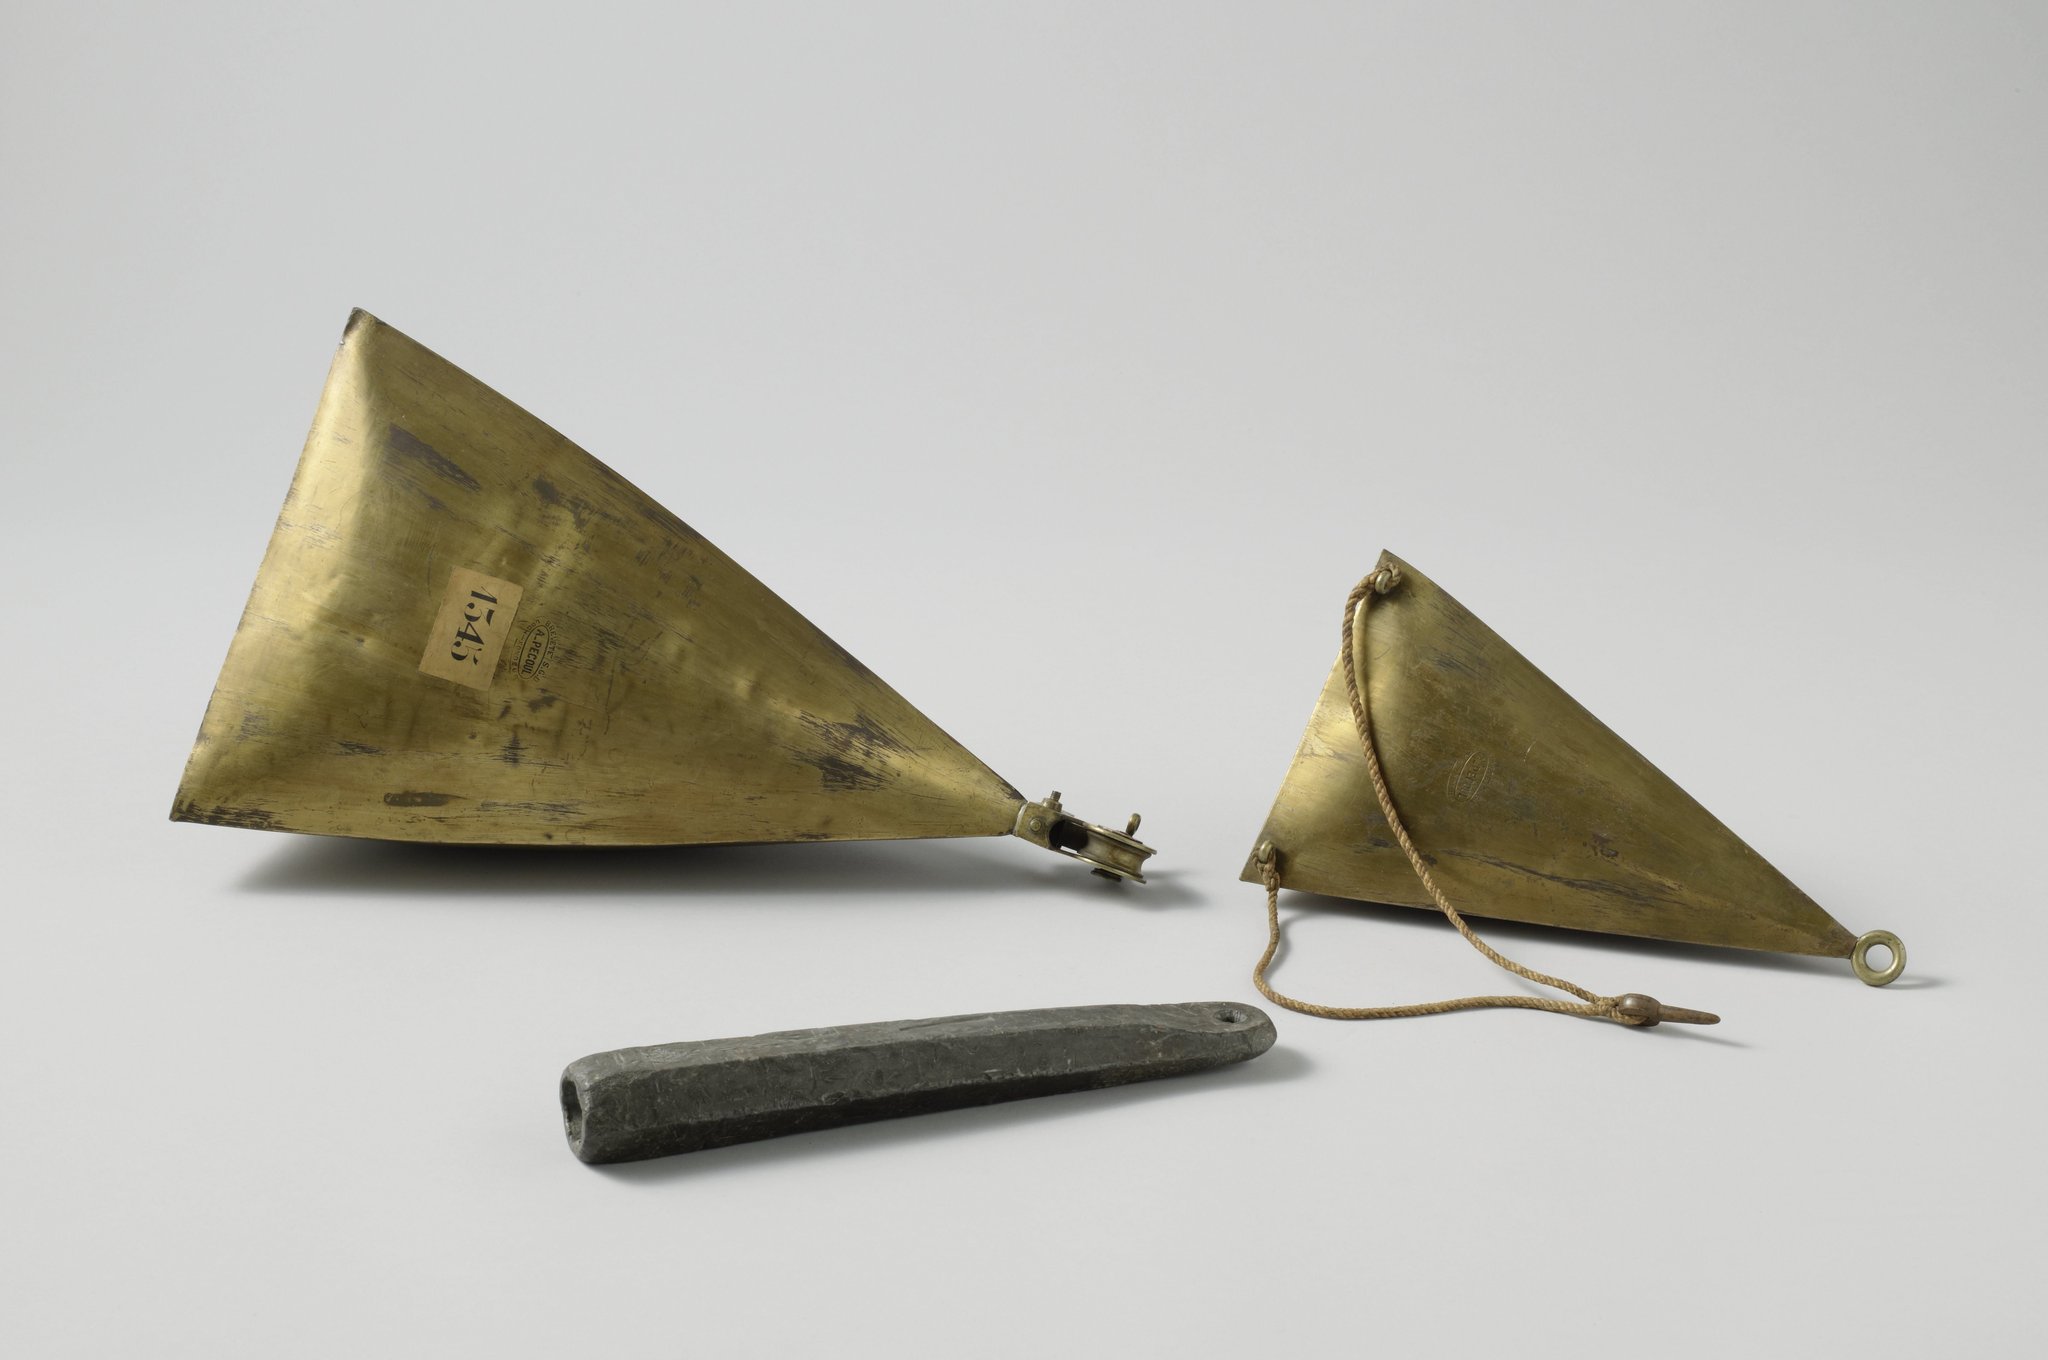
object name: lead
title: Sounding Log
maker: adolphe pécoul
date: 1855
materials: lead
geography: marseille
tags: paris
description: Pécoul's uitvinding, zoals beschreven in de brochure, werkte met slechts één boei, die zowel als log en als dieplood werd gebruikt. Indien als log gebruikt, werd de boei met het lood op een vastgestelde afstand verzwaard en de pal in het houten cilindertje op het viertouw gestoken, zodat de boei met zijn punt naar beneden in het water komt te liggen en een vlakke kant aan de vaarrichting biedt: zo gauw als het viertouw strak komt te staan, laat de pal los. Zoals bij een gewoon log wordt de snelheid van het schip afgeleid uit de lengte van het gevierde touw in een bepaalde tijd. Het gebruik van het lood maakte het minder gevoelig voor stromingen.